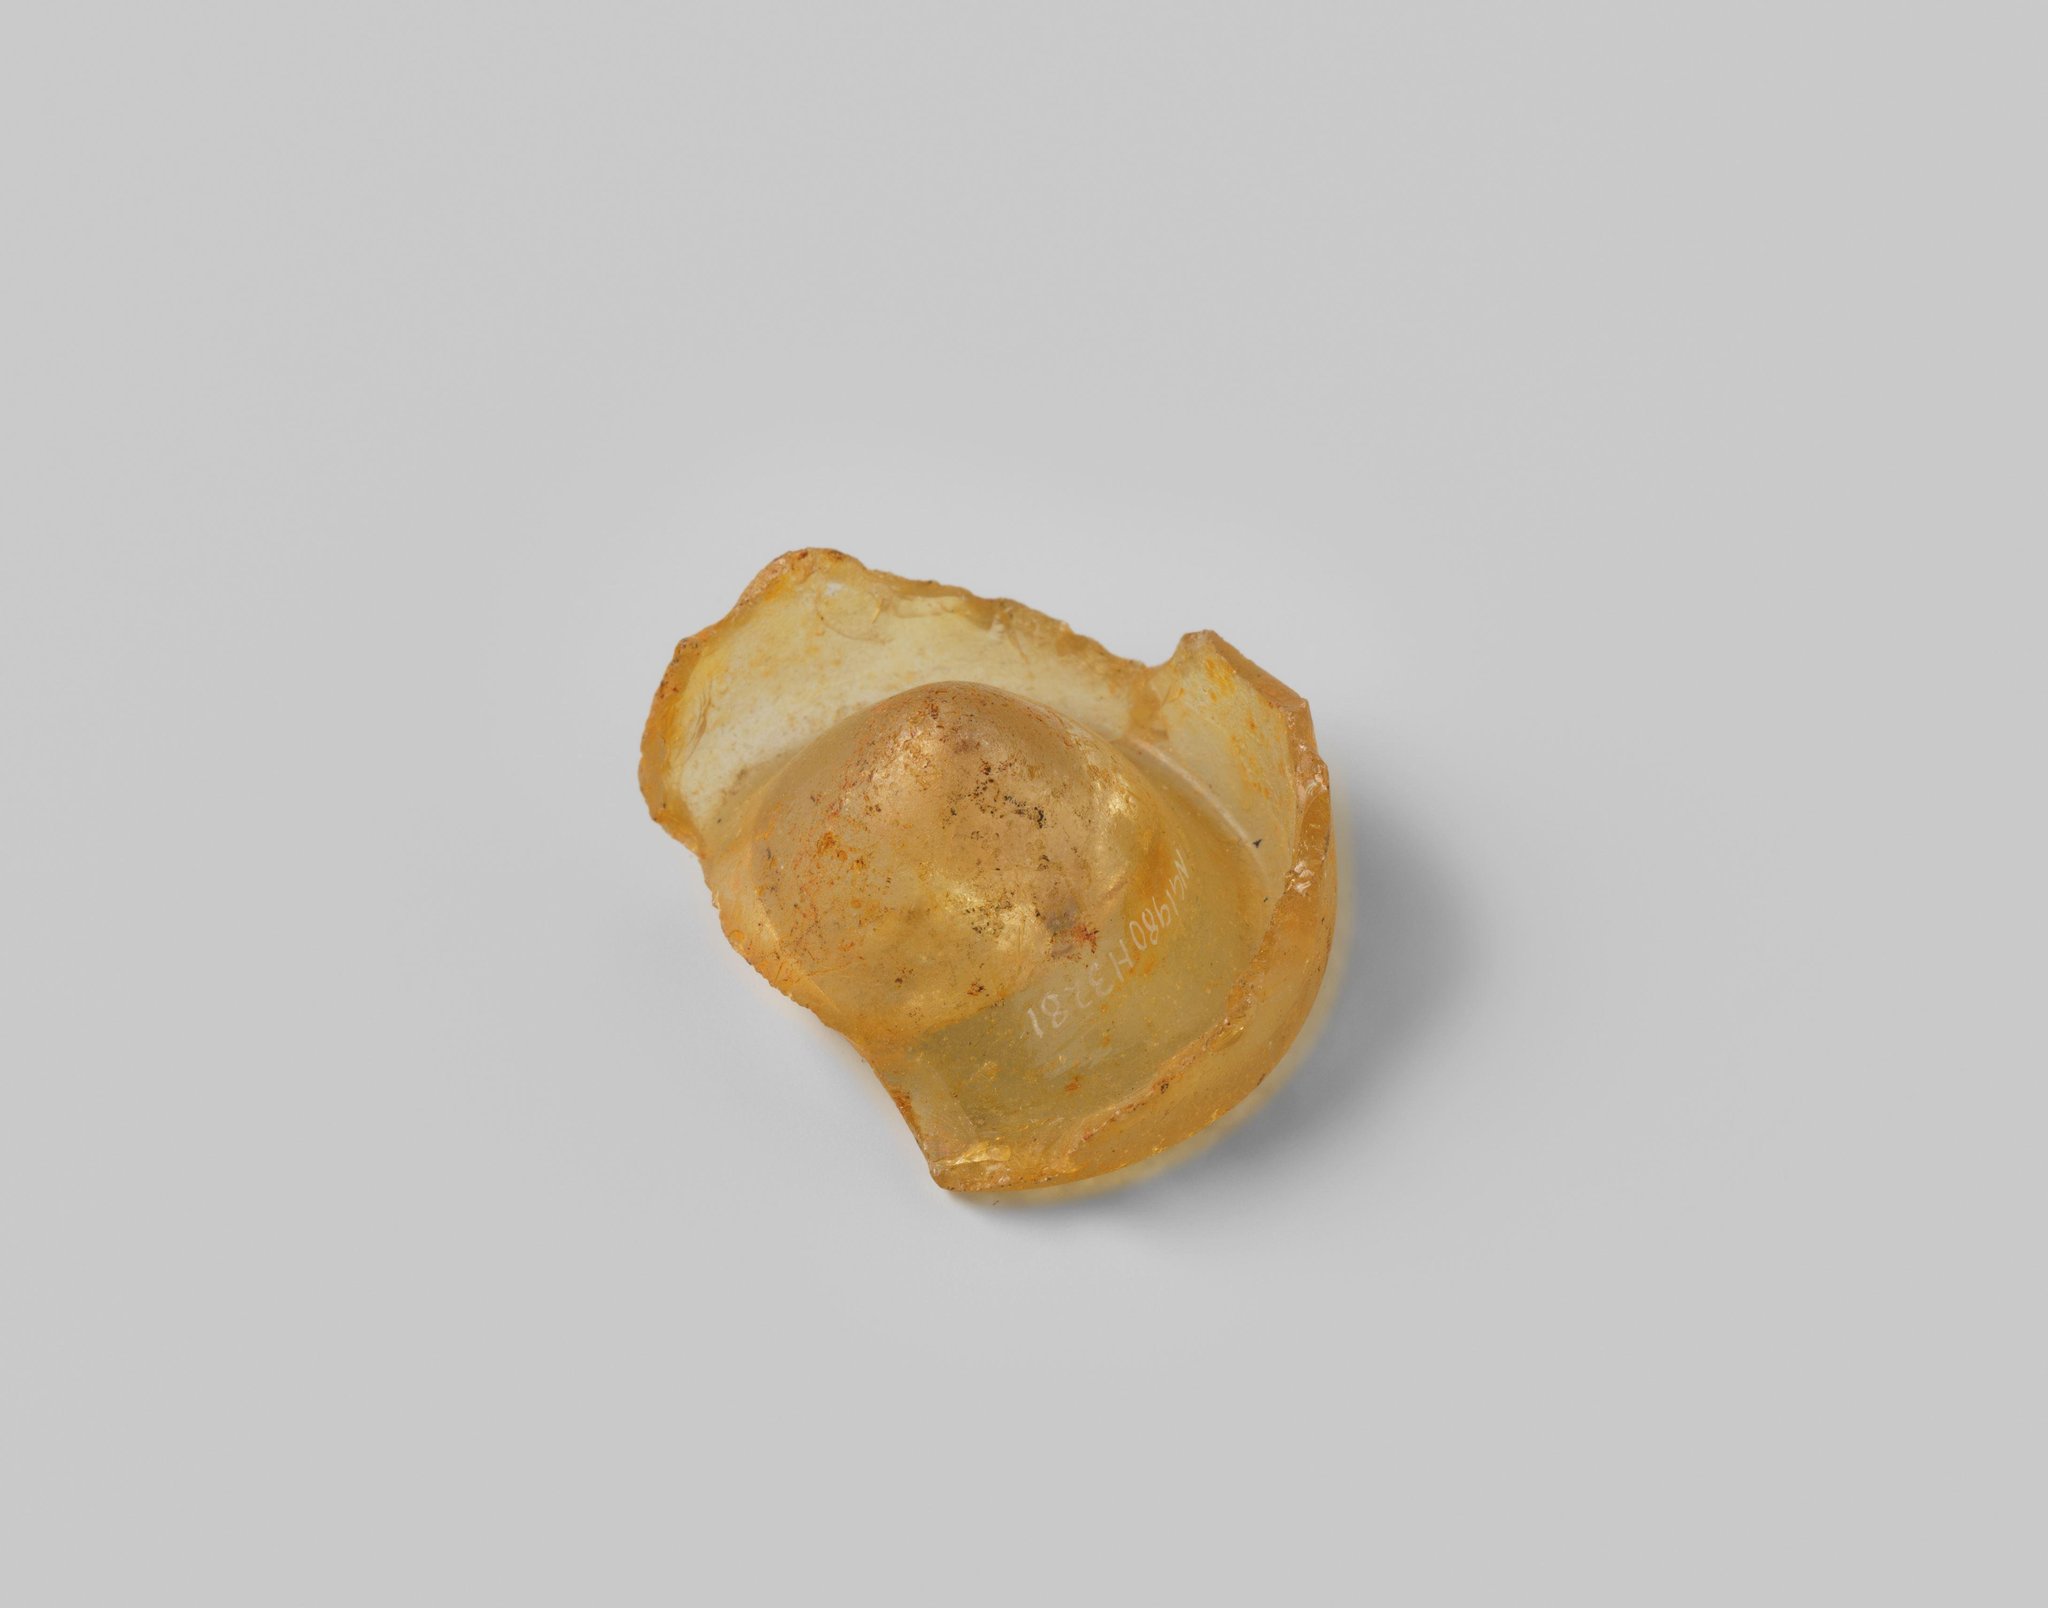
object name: medicine bottle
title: Fragment medicijn- of parfumfles uit het wrak van de Oost-Indiëvaarder Hollandia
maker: Anonymous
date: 1700-1743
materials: glass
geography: netherlands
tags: verenigde oostindische compagnie, hollandia (schip), annet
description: Medicine bottle, perfume bottle; fragm of base, id. NG 1980-27H983.